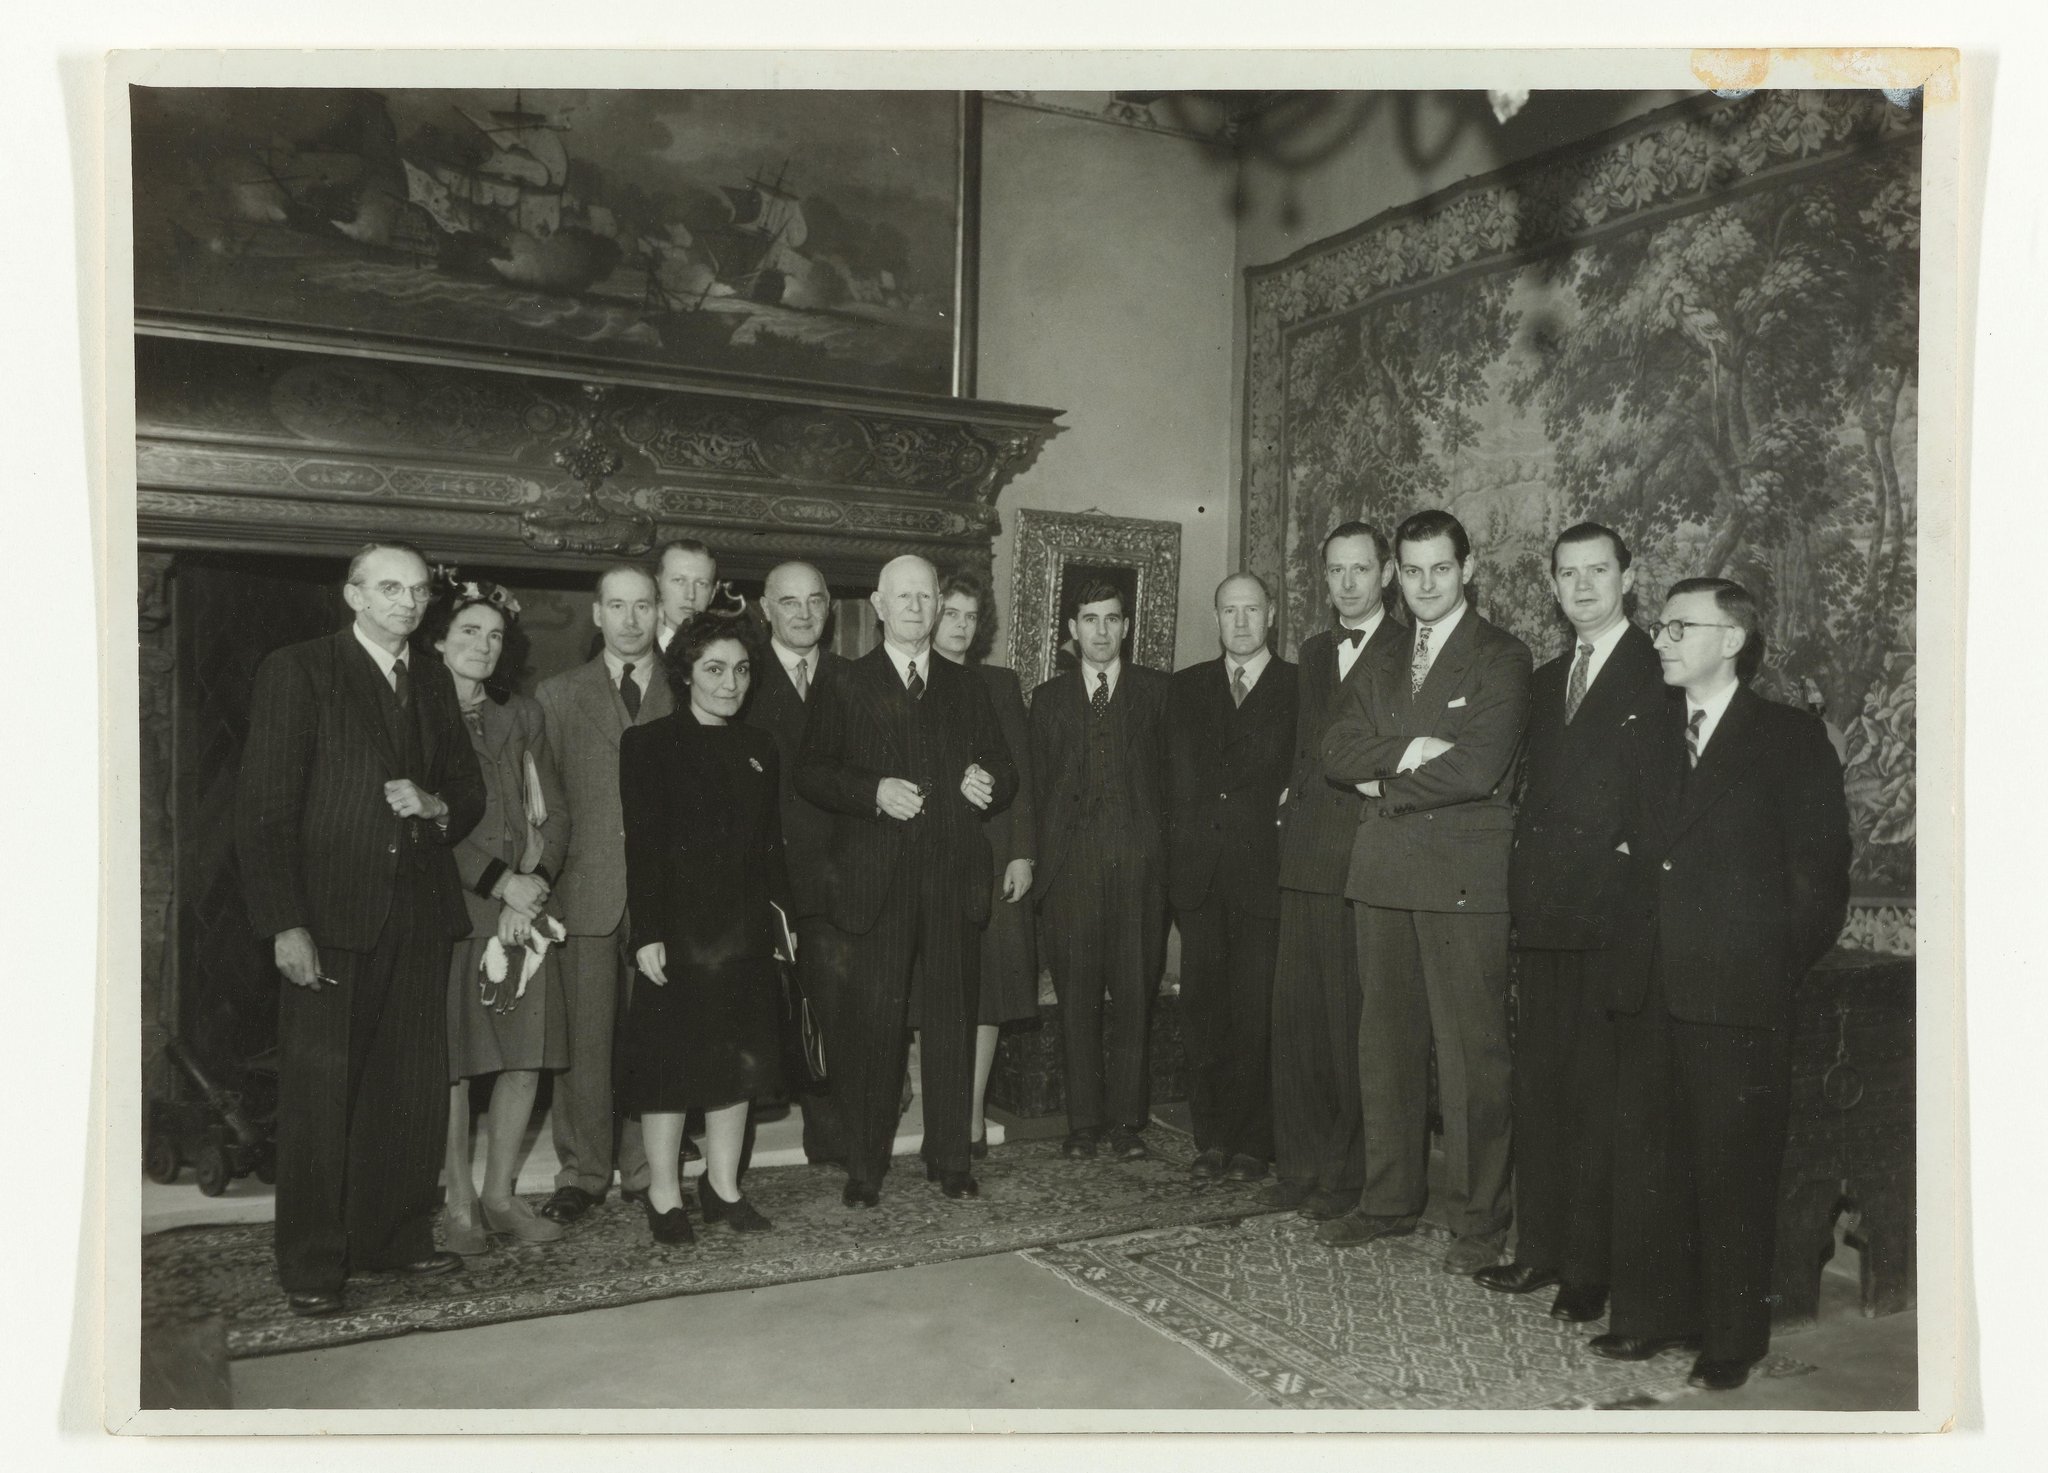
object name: photograph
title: Liberaal Internationaal Congres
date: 1948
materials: photographic support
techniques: photography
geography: amsterdam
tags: tonny van renterghem, netherlands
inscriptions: inscription: ‘In de politiek. Poging tot het vormen van een vroege 'common market', het liberale internationale congres le 5 fefrier 1948 à Amsterdam. Photo pris chez Tonny van Renterghem, Gabriel Mesustraat 9 on la réunion mondial a tenue les..... Il manque plusieurs délégués sur la photo!’, signature: ‘Fotopersbureau Lindeman, Weteringsschans 89, Amsterdam-C.’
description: Groepsfoto waarvan de derde van rechts Tonny van Renterghem is. Op de achtergrond een monumentale schouw met daarboven een schilderij van een zeeslag. Rechts aan de muur een tapijt.